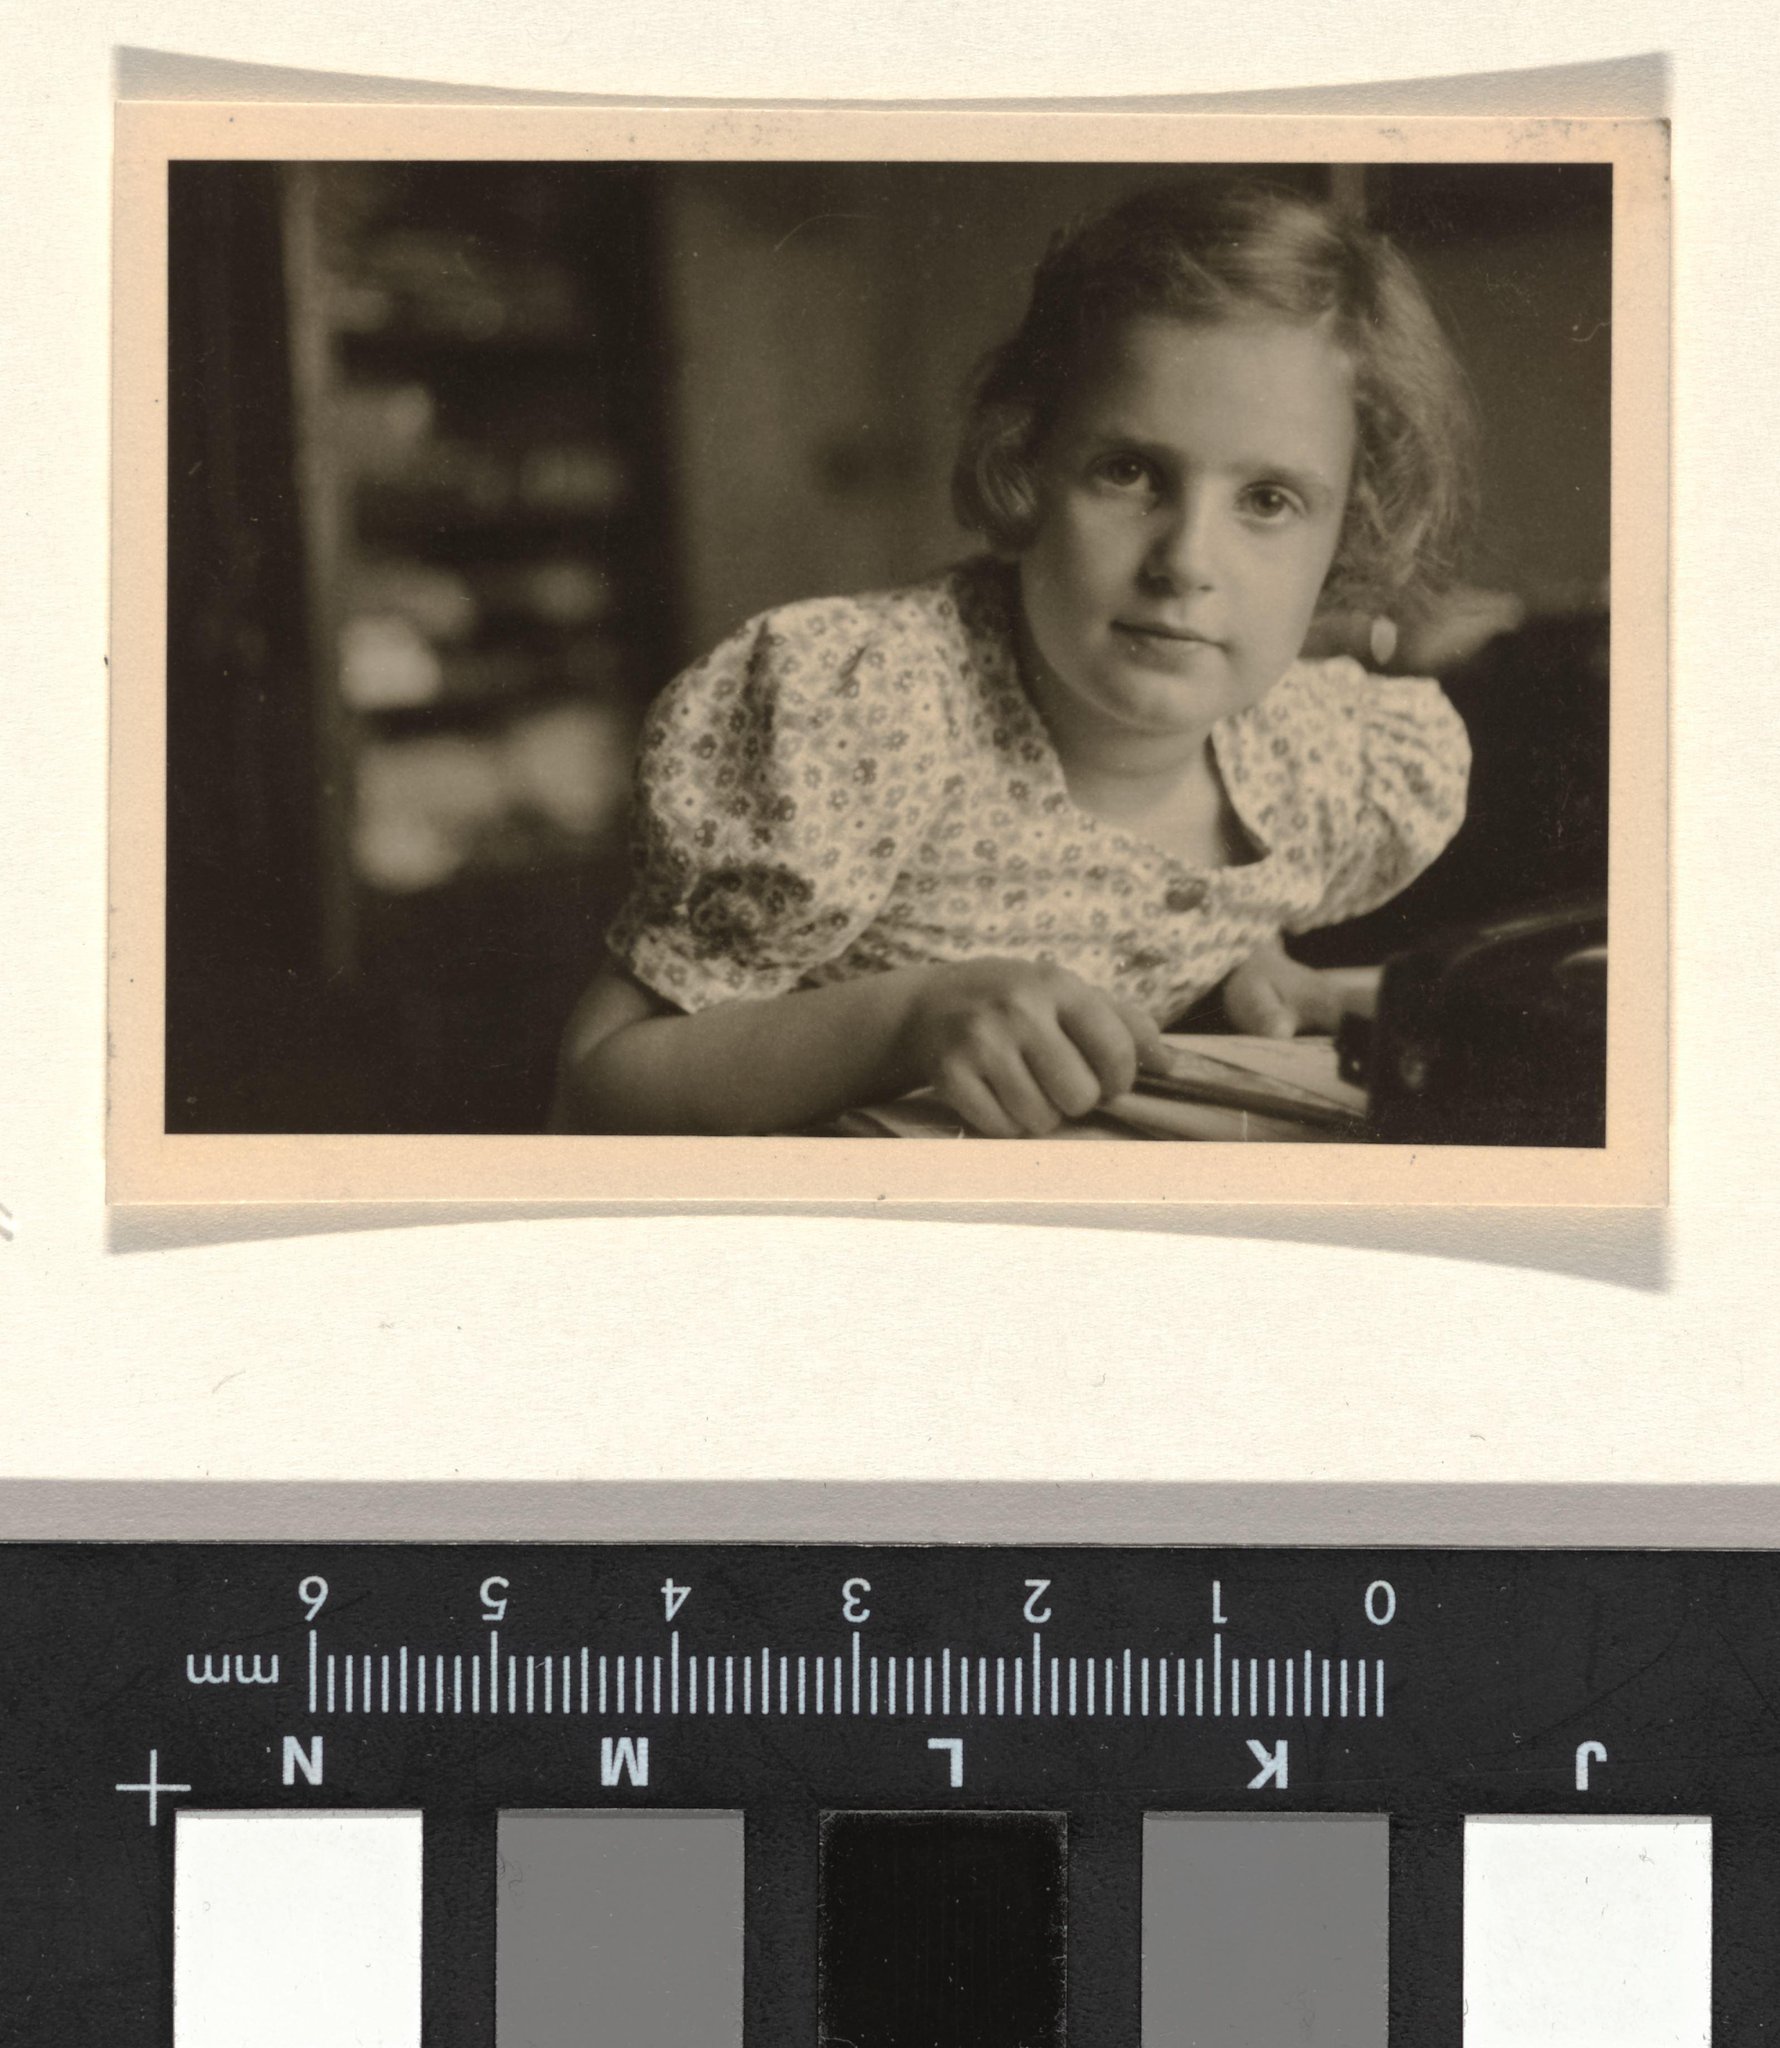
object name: photograph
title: Photographs from the Estate of Isabel Wachenheimer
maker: Anonymous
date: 1907-1936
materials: photographic support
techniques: gelatin silver print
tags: leiden, isabel wachenheimer-elon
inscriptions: date: ‘Juli 1936’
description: In 1928 a daughter, Isabel, was born to Eugen and Else Wachenheimer. In 1934 they posed before the family home in Stuttgart on Isabel’s first day of school. The photograph at the lower right was taken almost ten years later (1943) in the Westerbork transit camp. Isabel had been rounded up in Amsterdam five months earlier. The family was first sent to Theresienstadt and then on to Auschwitz-Birkenau, where Eugen and Else were gassed. Isabel was condemned to forced labour.